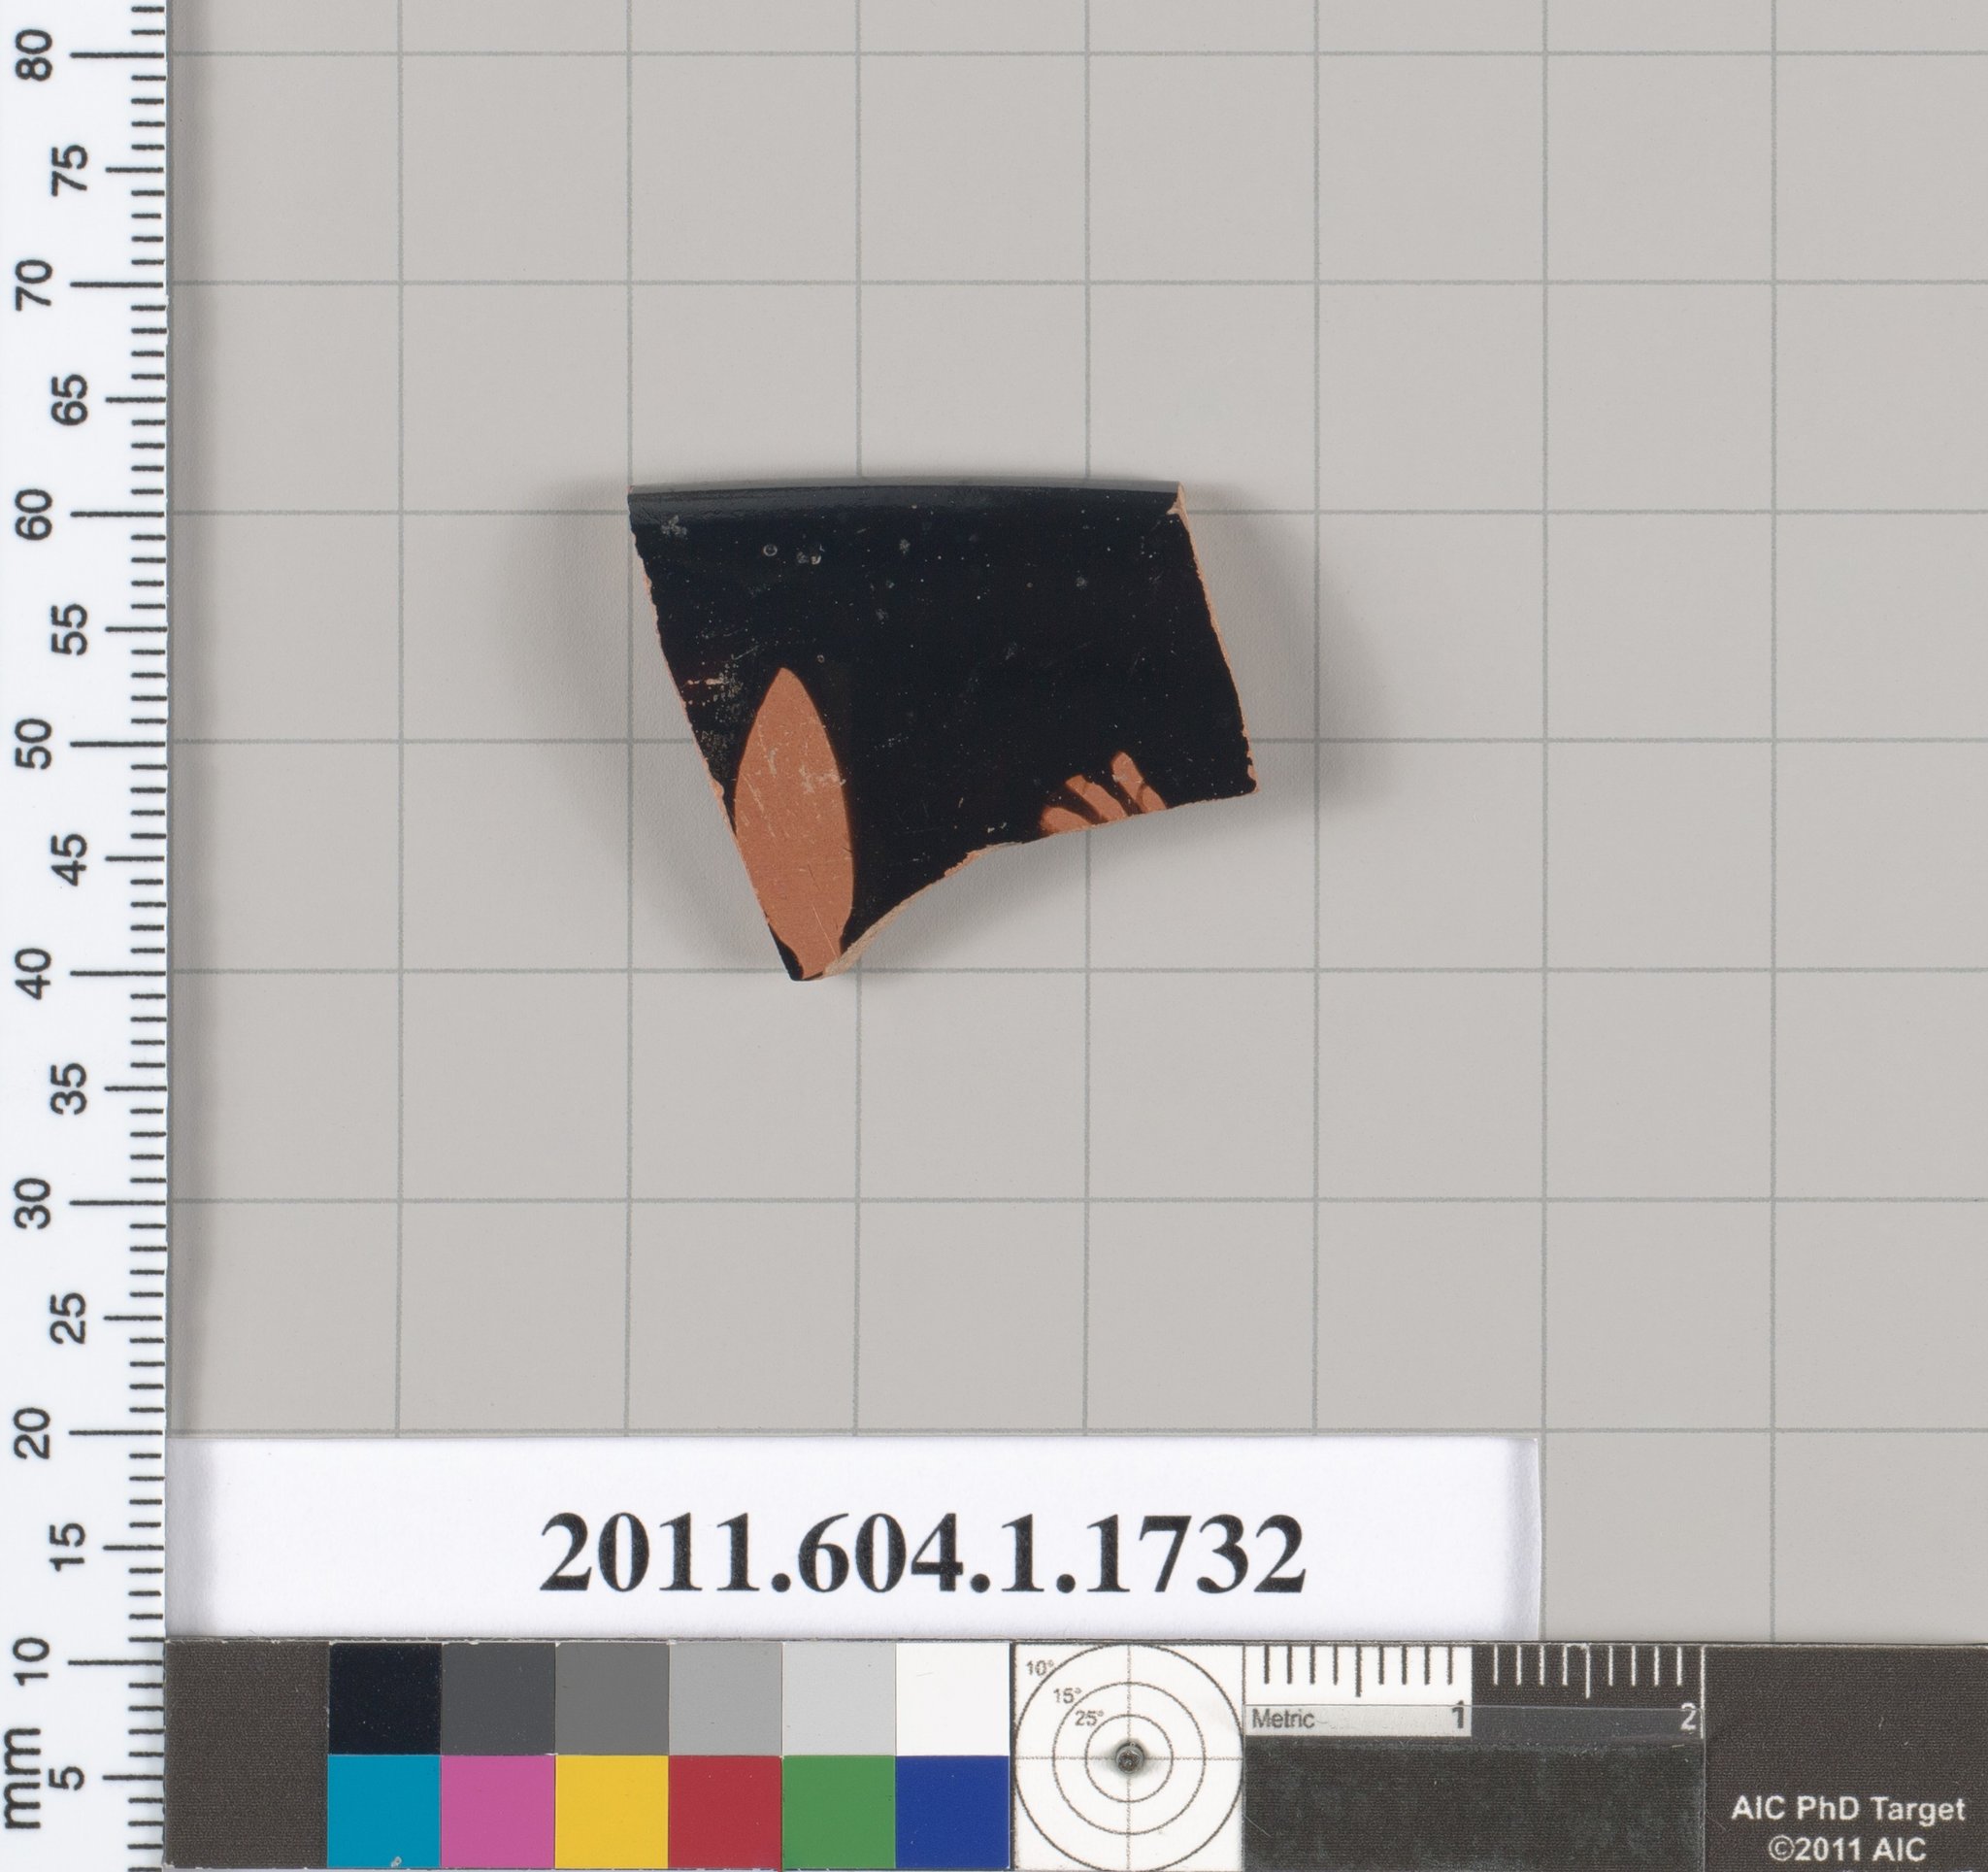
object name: kylix fragment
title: Terracotta rim fragment of a kylix (drinking cup)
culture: greek, attic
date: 475-451 BCE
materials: terracotta